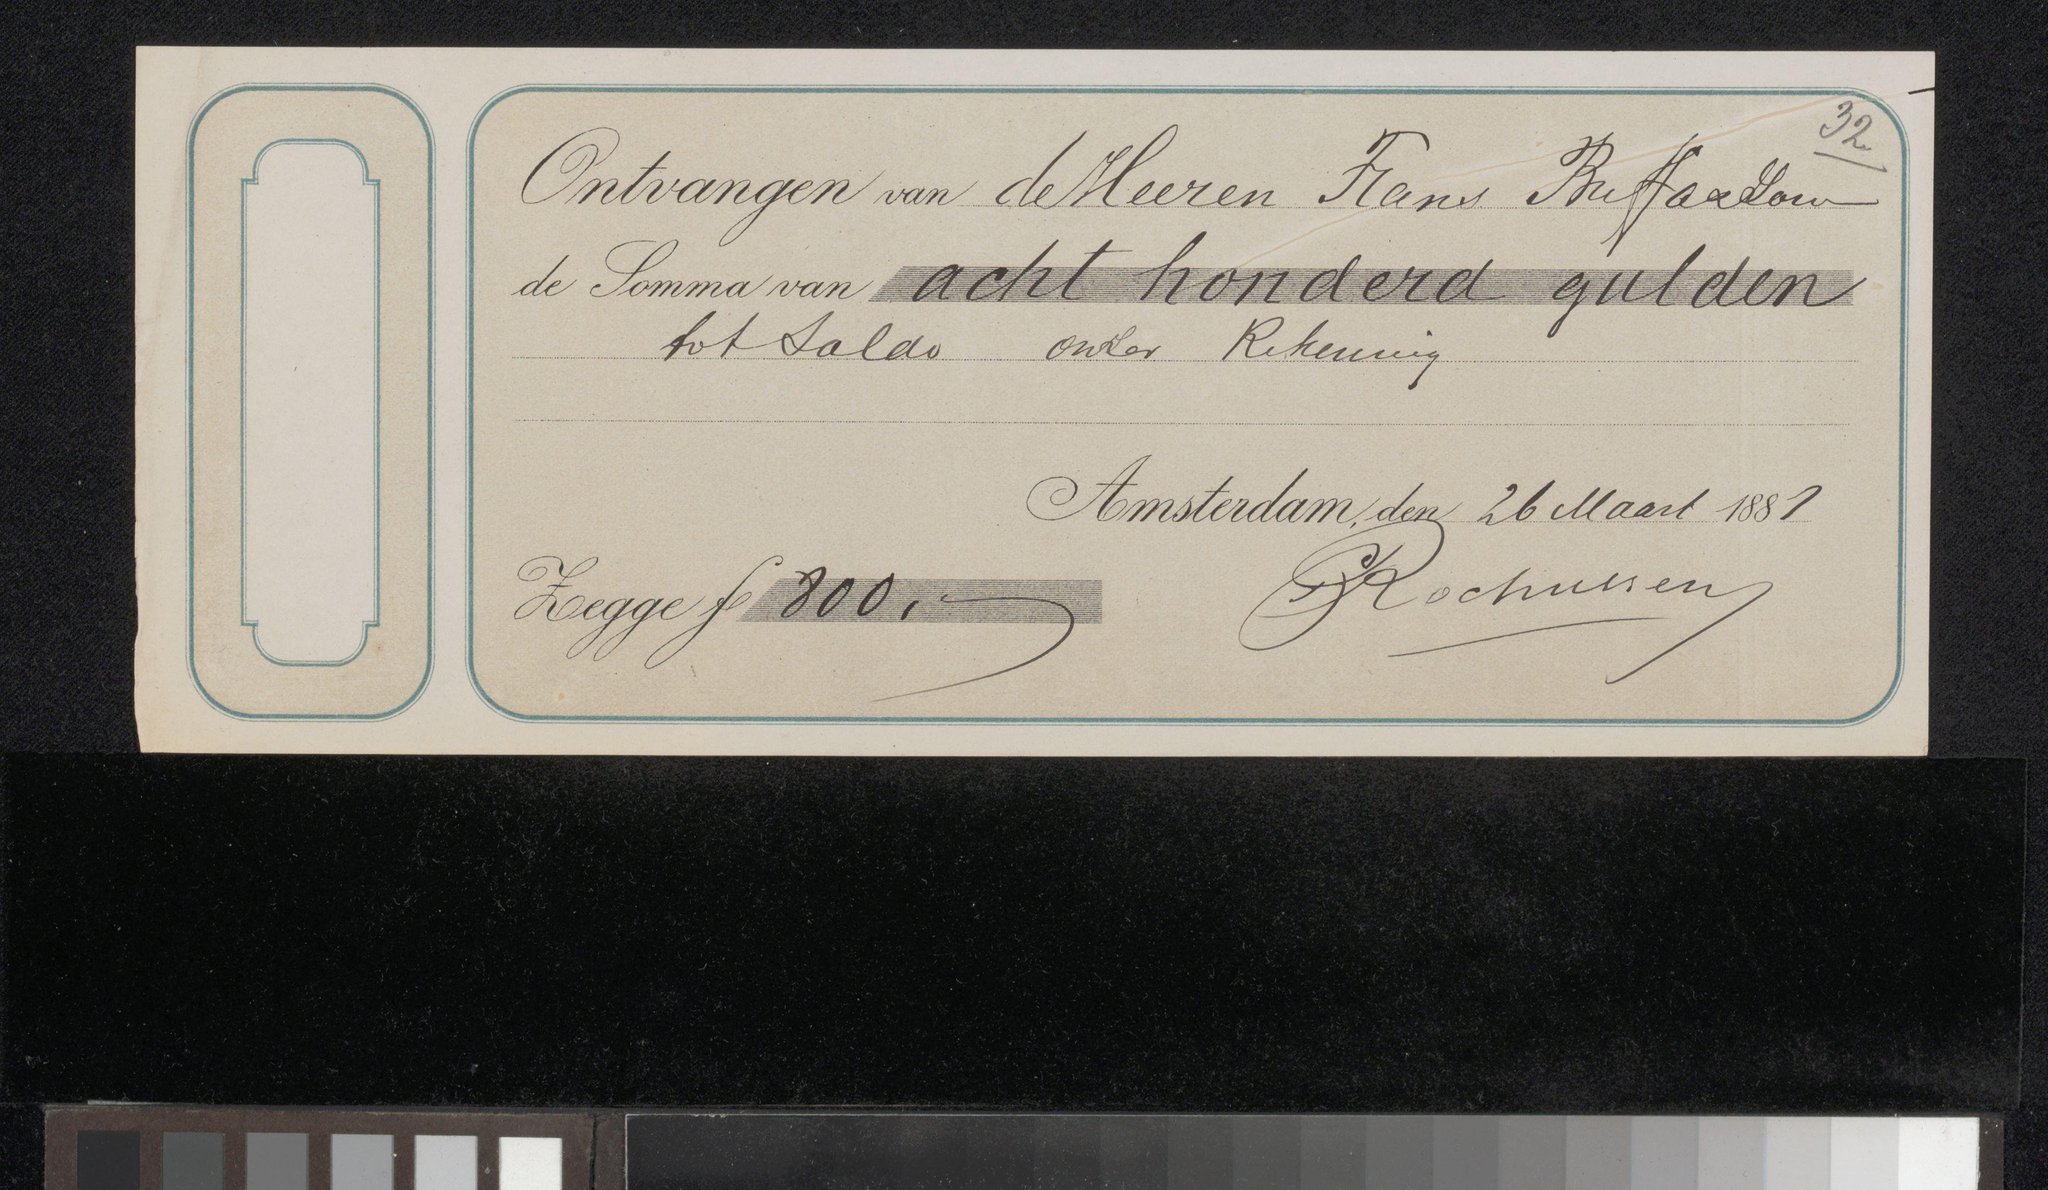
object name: ontvangstbewijs, kwitantie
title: Kwitantie voor Charles Rochussen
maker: charles rochussen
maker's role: draughtsman, painter, print maker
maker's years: 1814-1894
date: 1881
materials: ink, paper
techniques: pen, printing, writing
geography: amsterdam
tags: drawing, money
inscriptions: collector's mark: Lugt 2233